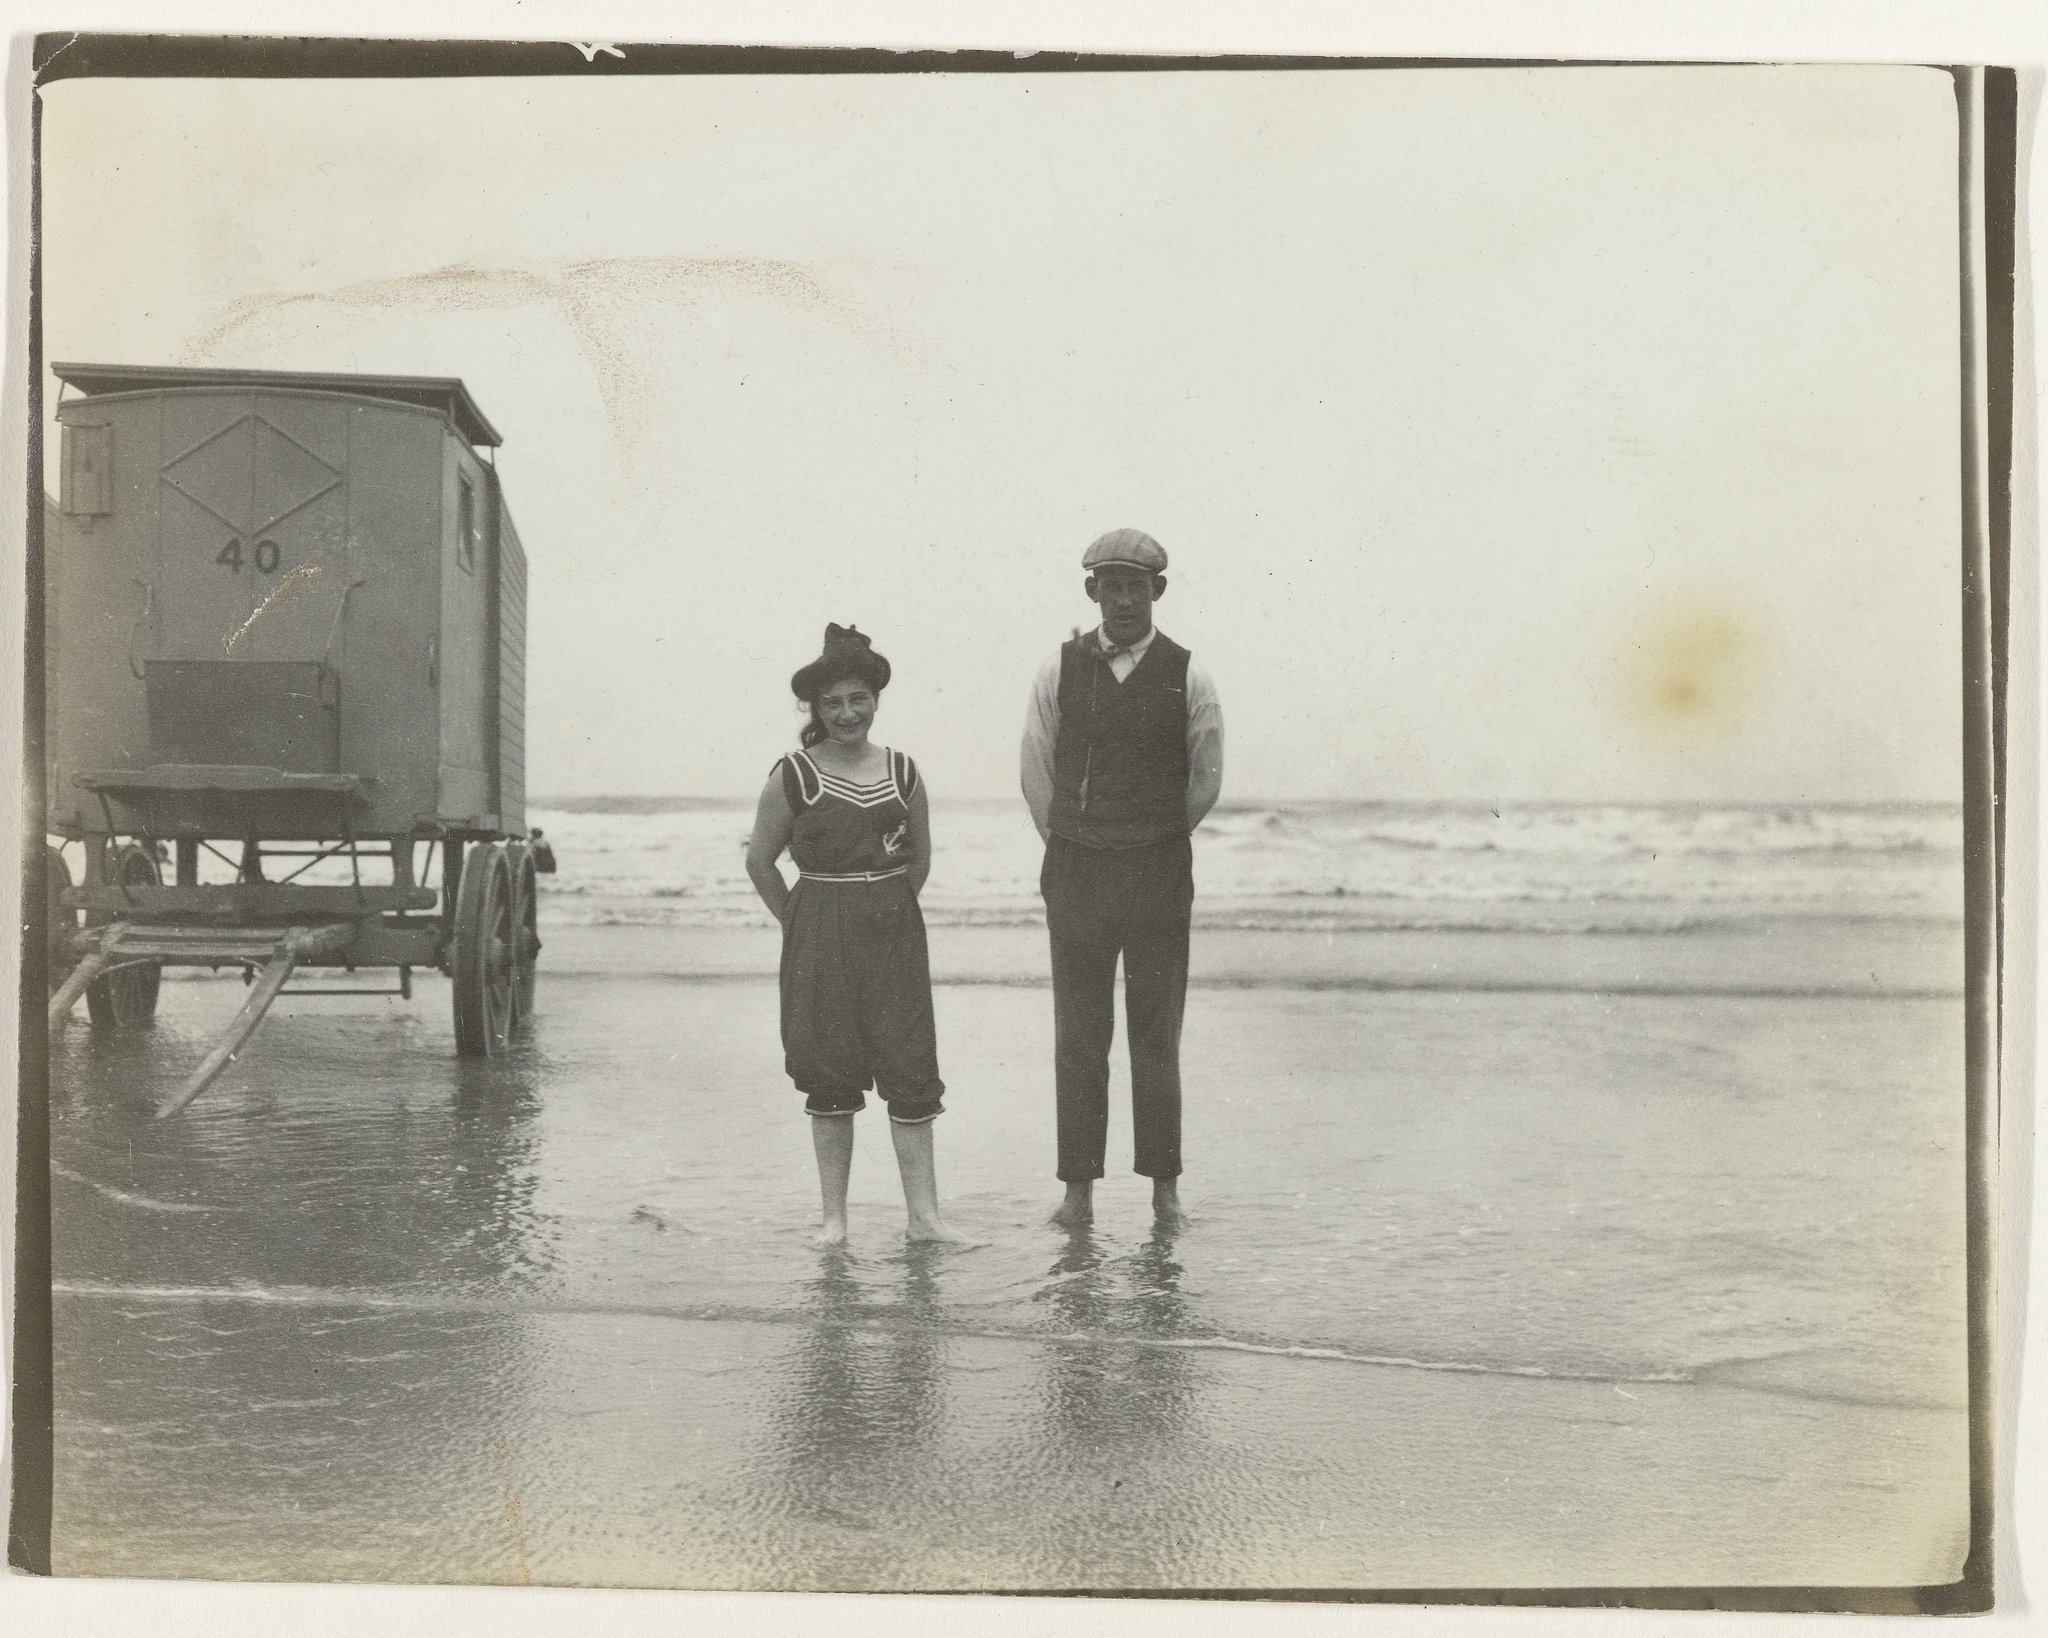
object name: photograph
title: Man en vrouw bij een badkoets (Noordzeekust), Nederland of Duitsland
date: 1900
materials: paper, photographic support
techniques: gelatin silver print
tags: in or beside the water (on the beach), netherlands, germany